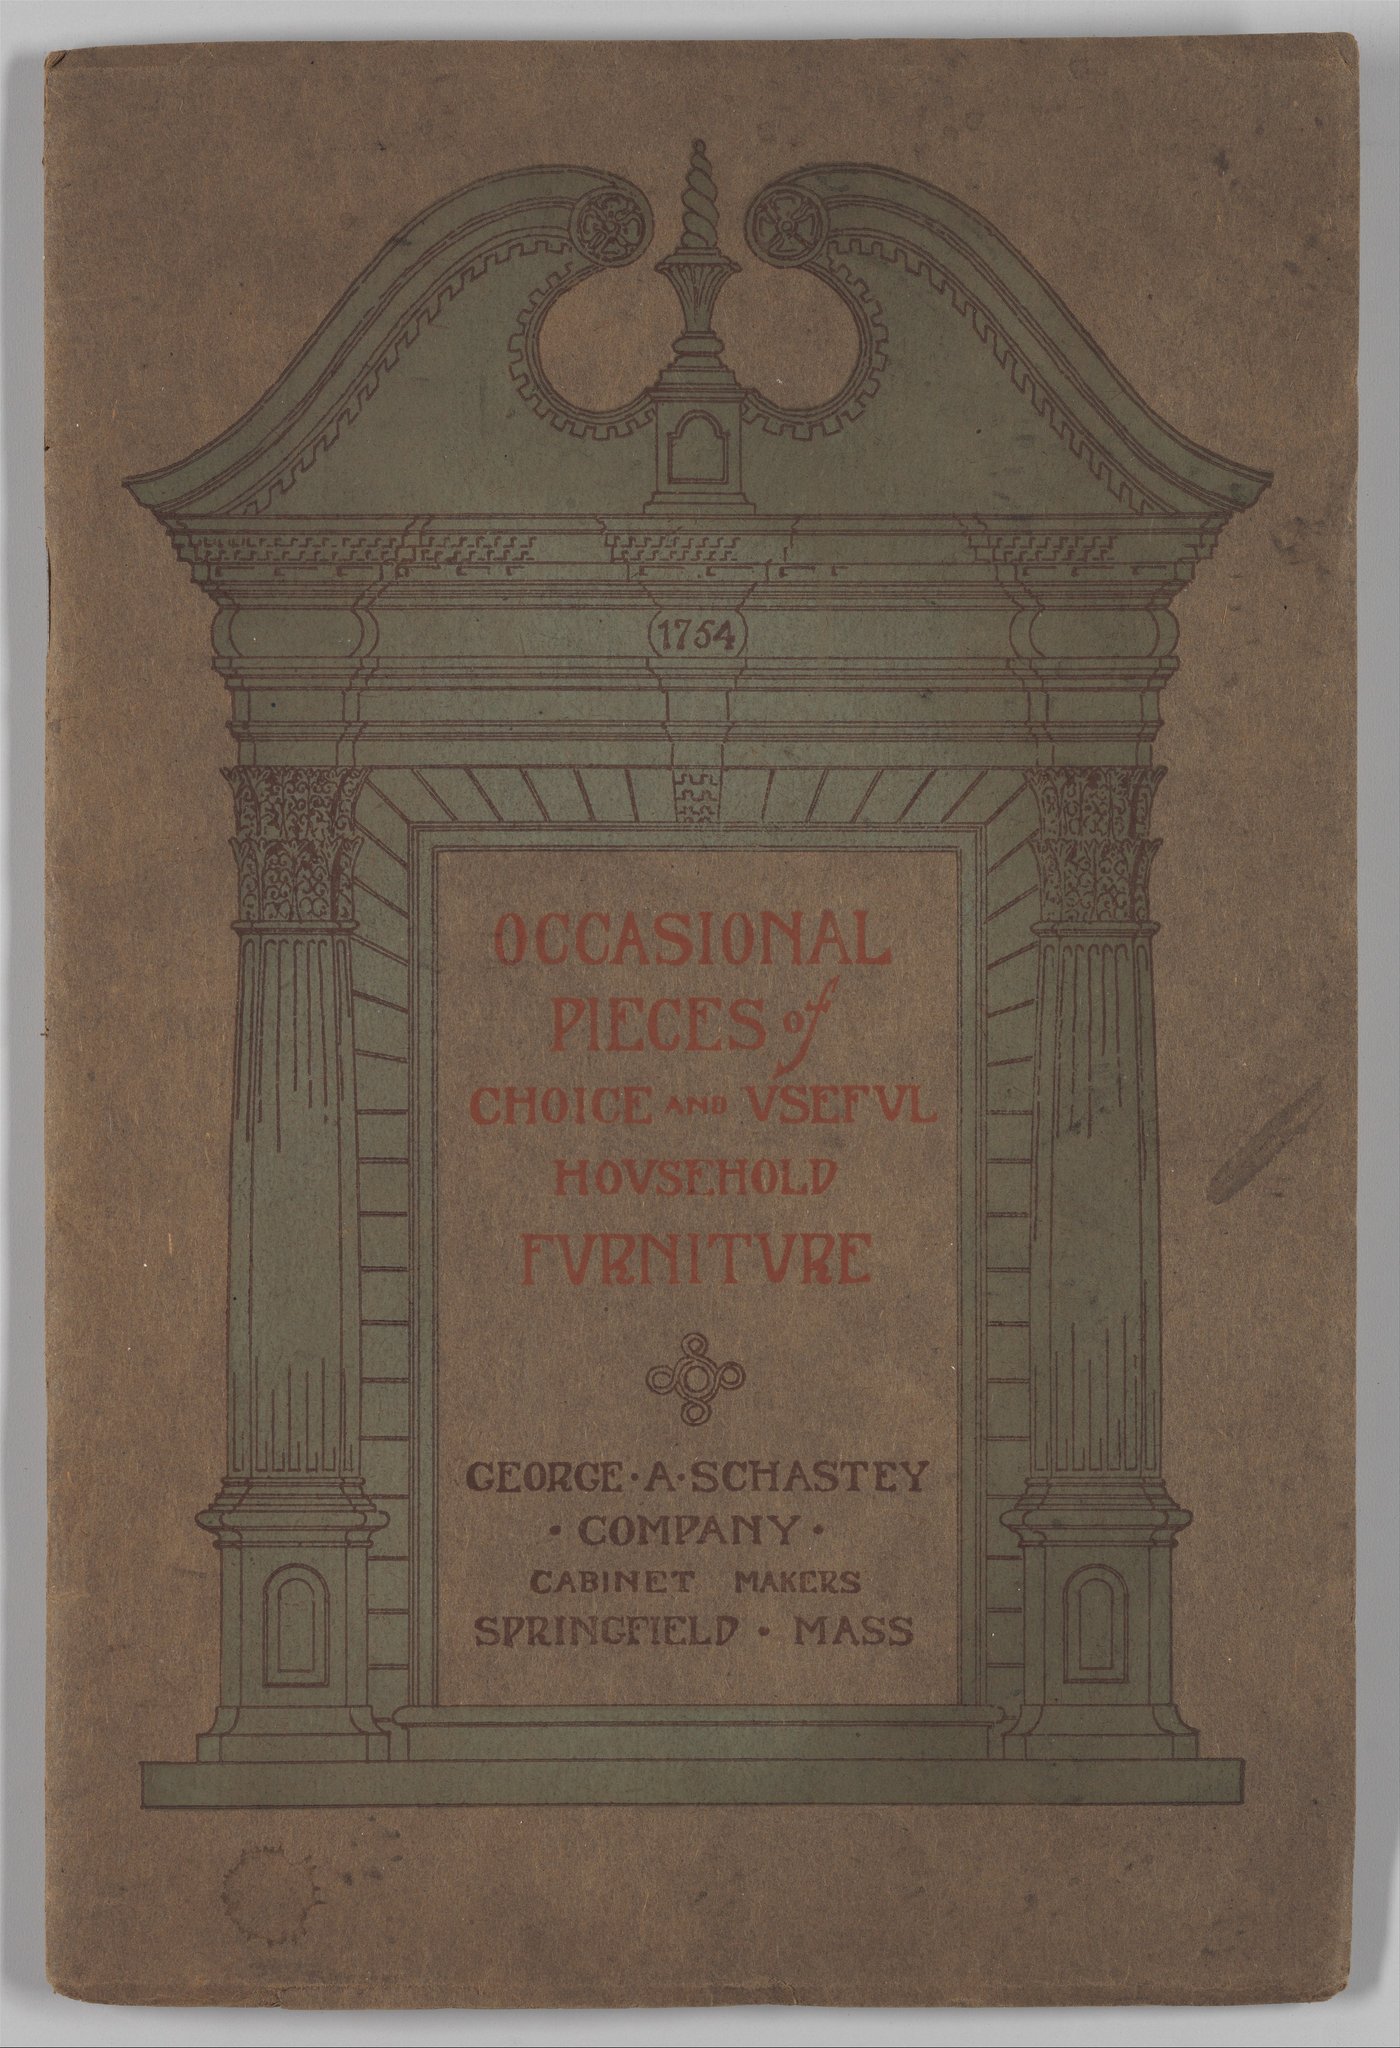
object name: trade catalogue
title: Occasional Pieces of Choice and Useful Household Furniture, Trade Catalogue (Springfield, MA: George A. Schastey Company)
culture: american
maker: george a. schastey & co.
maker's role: publisher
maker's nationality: american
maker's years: 1873-1897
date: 1890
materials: paper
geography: united states